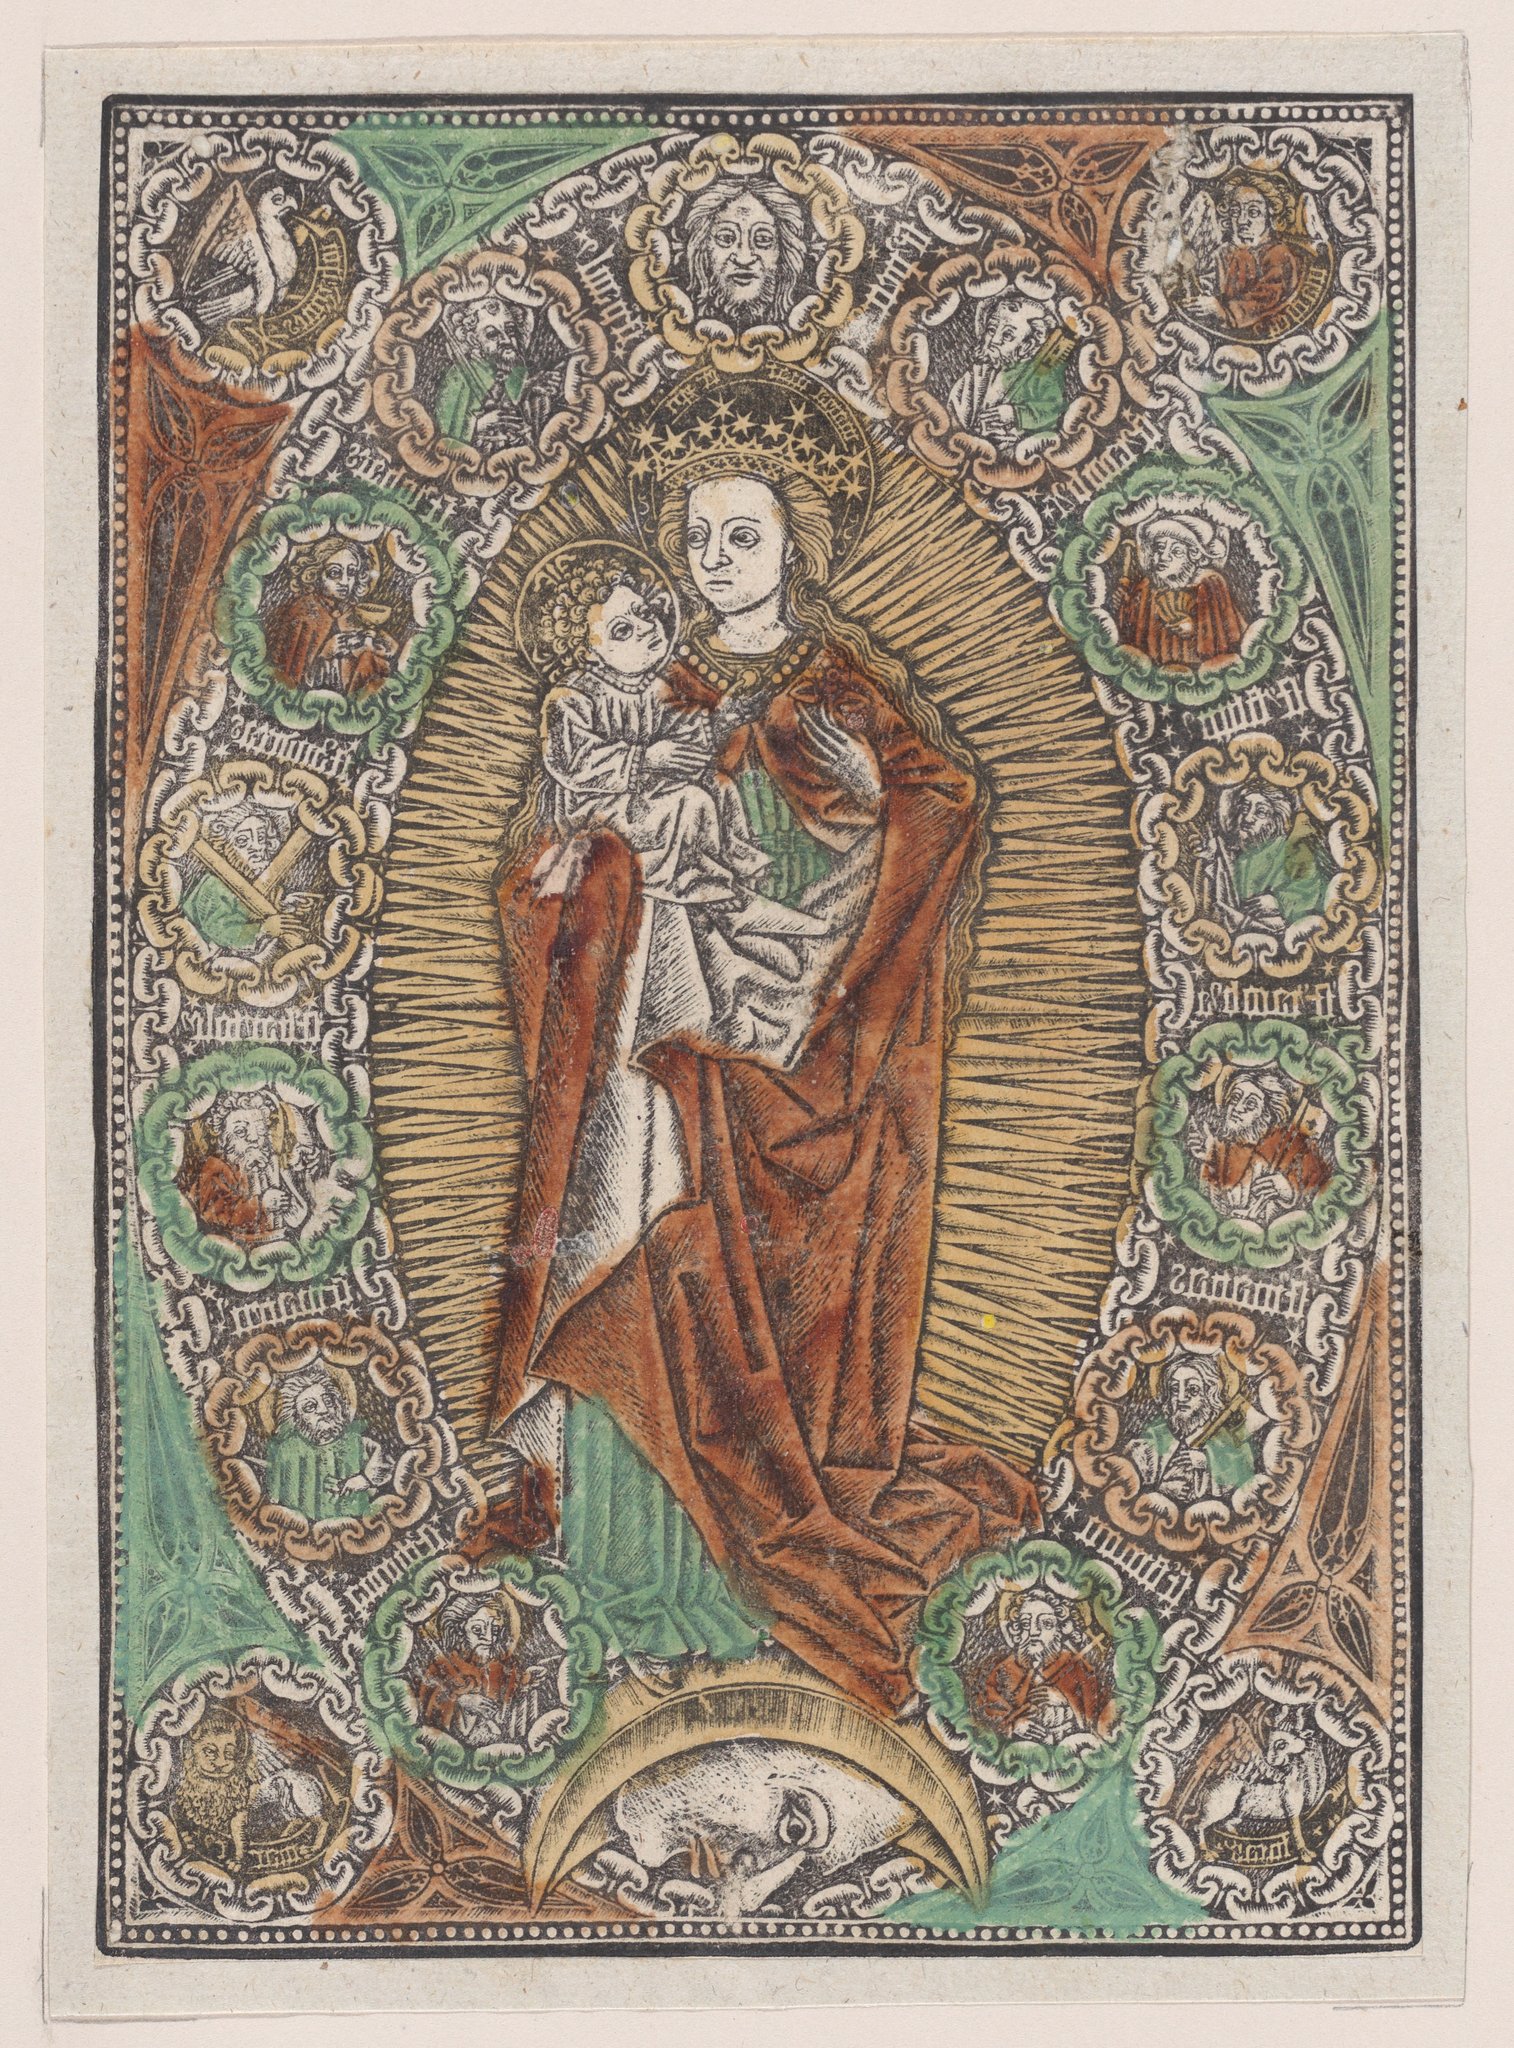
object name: print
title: The Virgin and Child on the Crescent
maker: anonymous, netherlandish, 15th century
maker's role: artist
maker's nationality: netherlandish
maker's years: 1400-1500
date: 1401-1500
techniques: hand coloring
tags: madonna and child